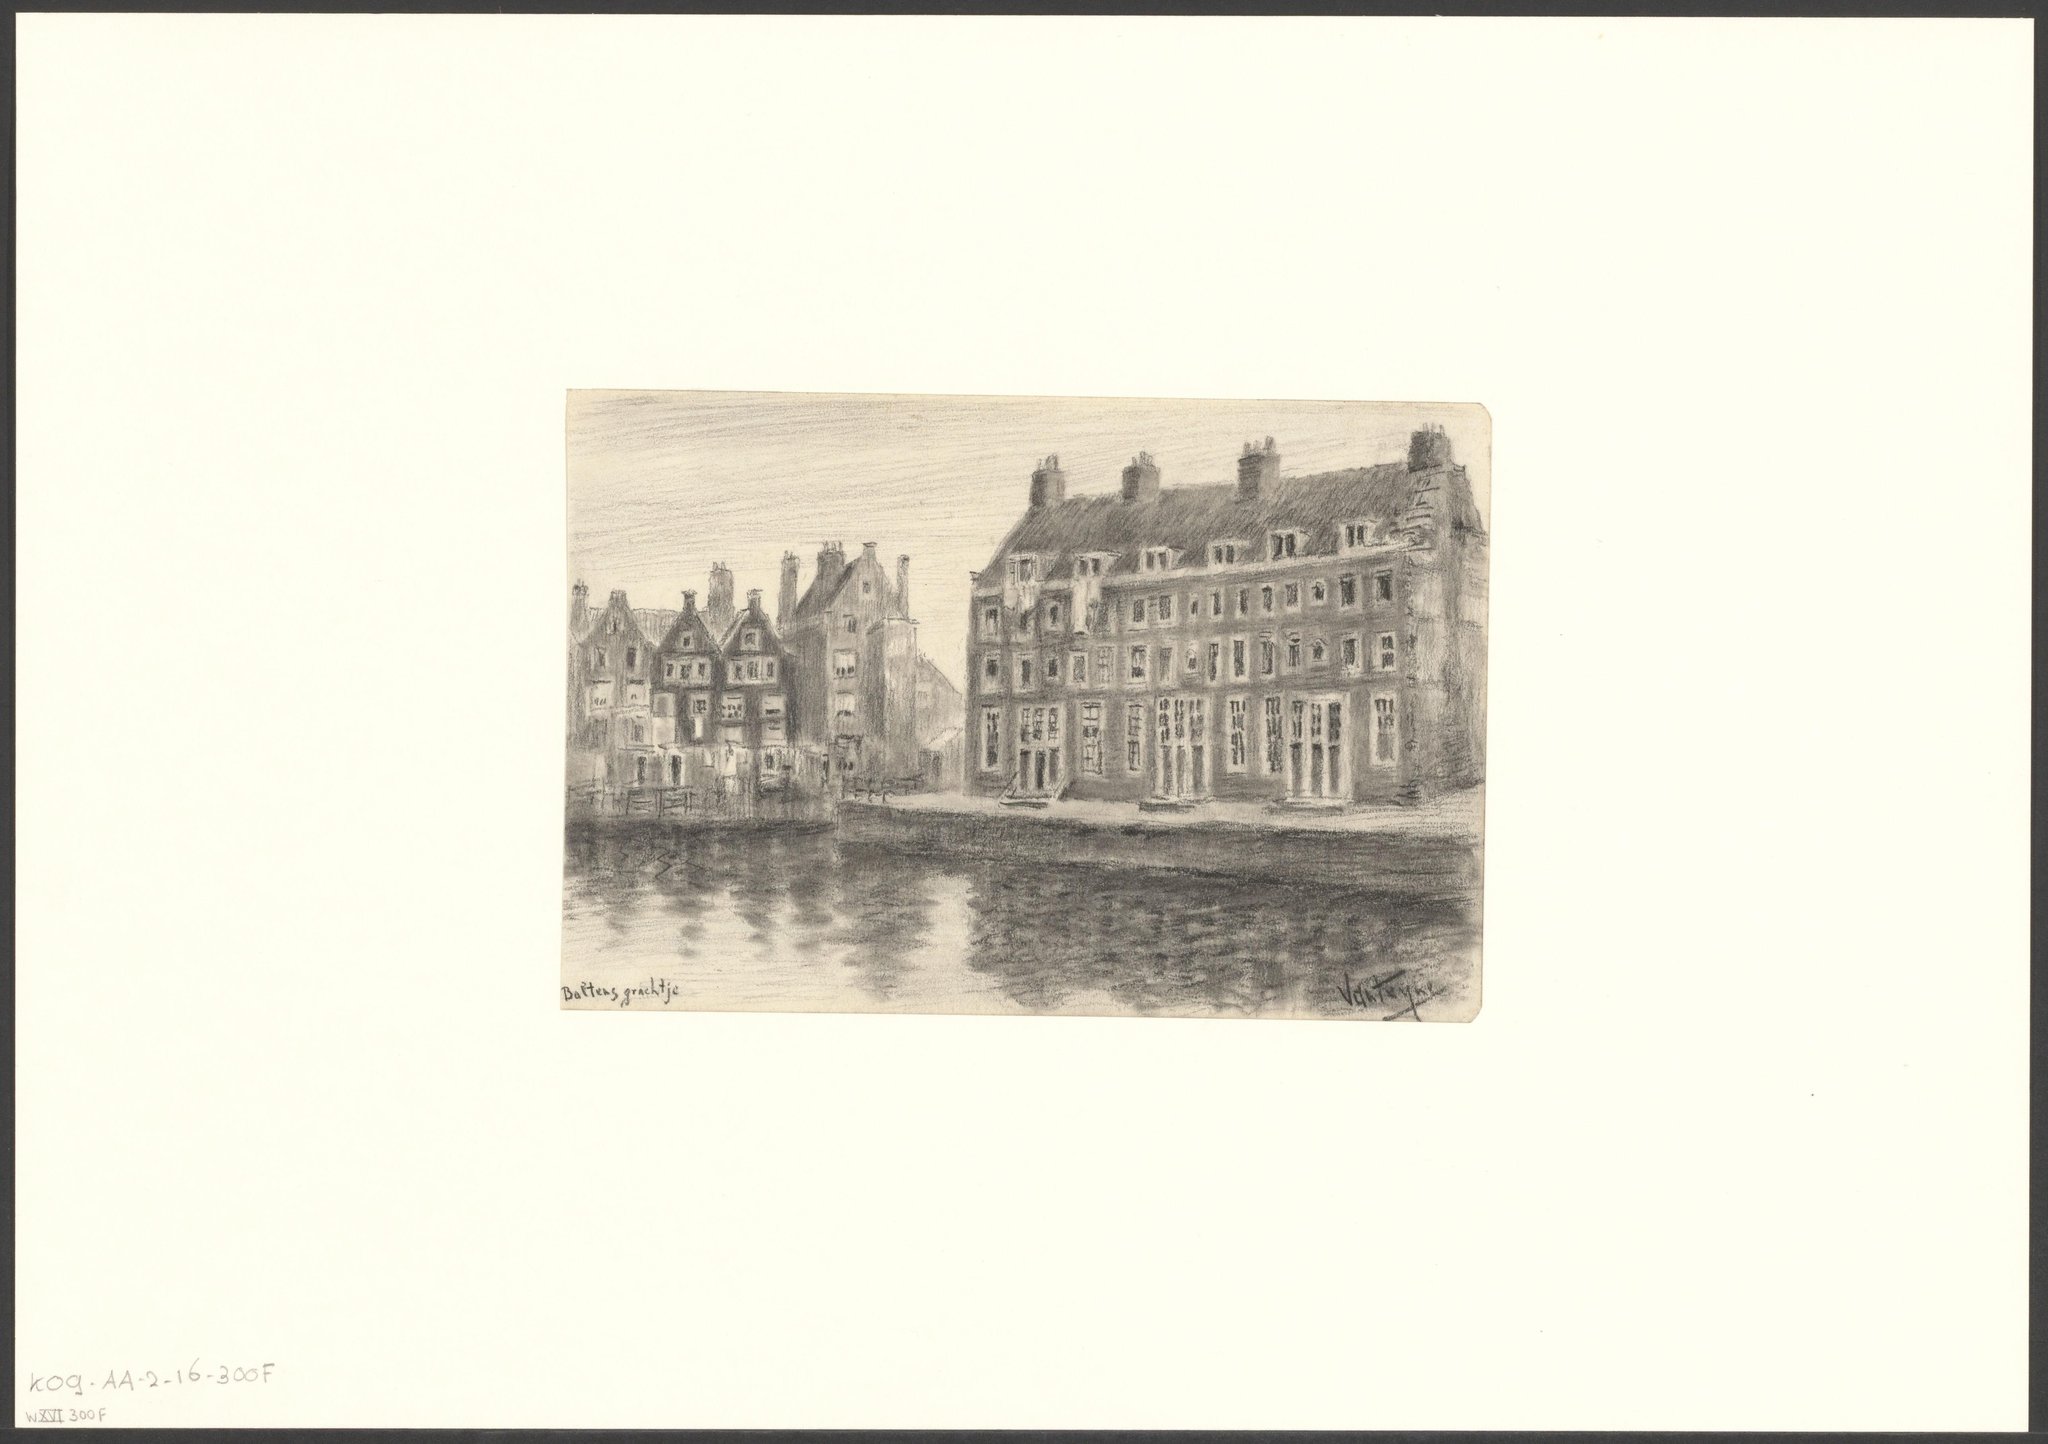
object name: drawing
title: Gezicht op het Boltensgrachtje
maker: anthonie van teijn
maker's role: draughtsman, painter, print maker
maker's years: 1863-1943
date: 1906-1927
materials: chalk, paper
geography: amsterdam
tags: city-view in general; 'veduta', canal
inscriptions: inscription: ‘Boltensgrachtje / geteekend door Ant van Teyn. / Juni 1927 / vEck’, inscription: ‘Boltensgrachtje’, signature: ‘VanTeyne’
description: Tekening binnen de Atlas Van Eck ingedeeld op wijknummer 16.